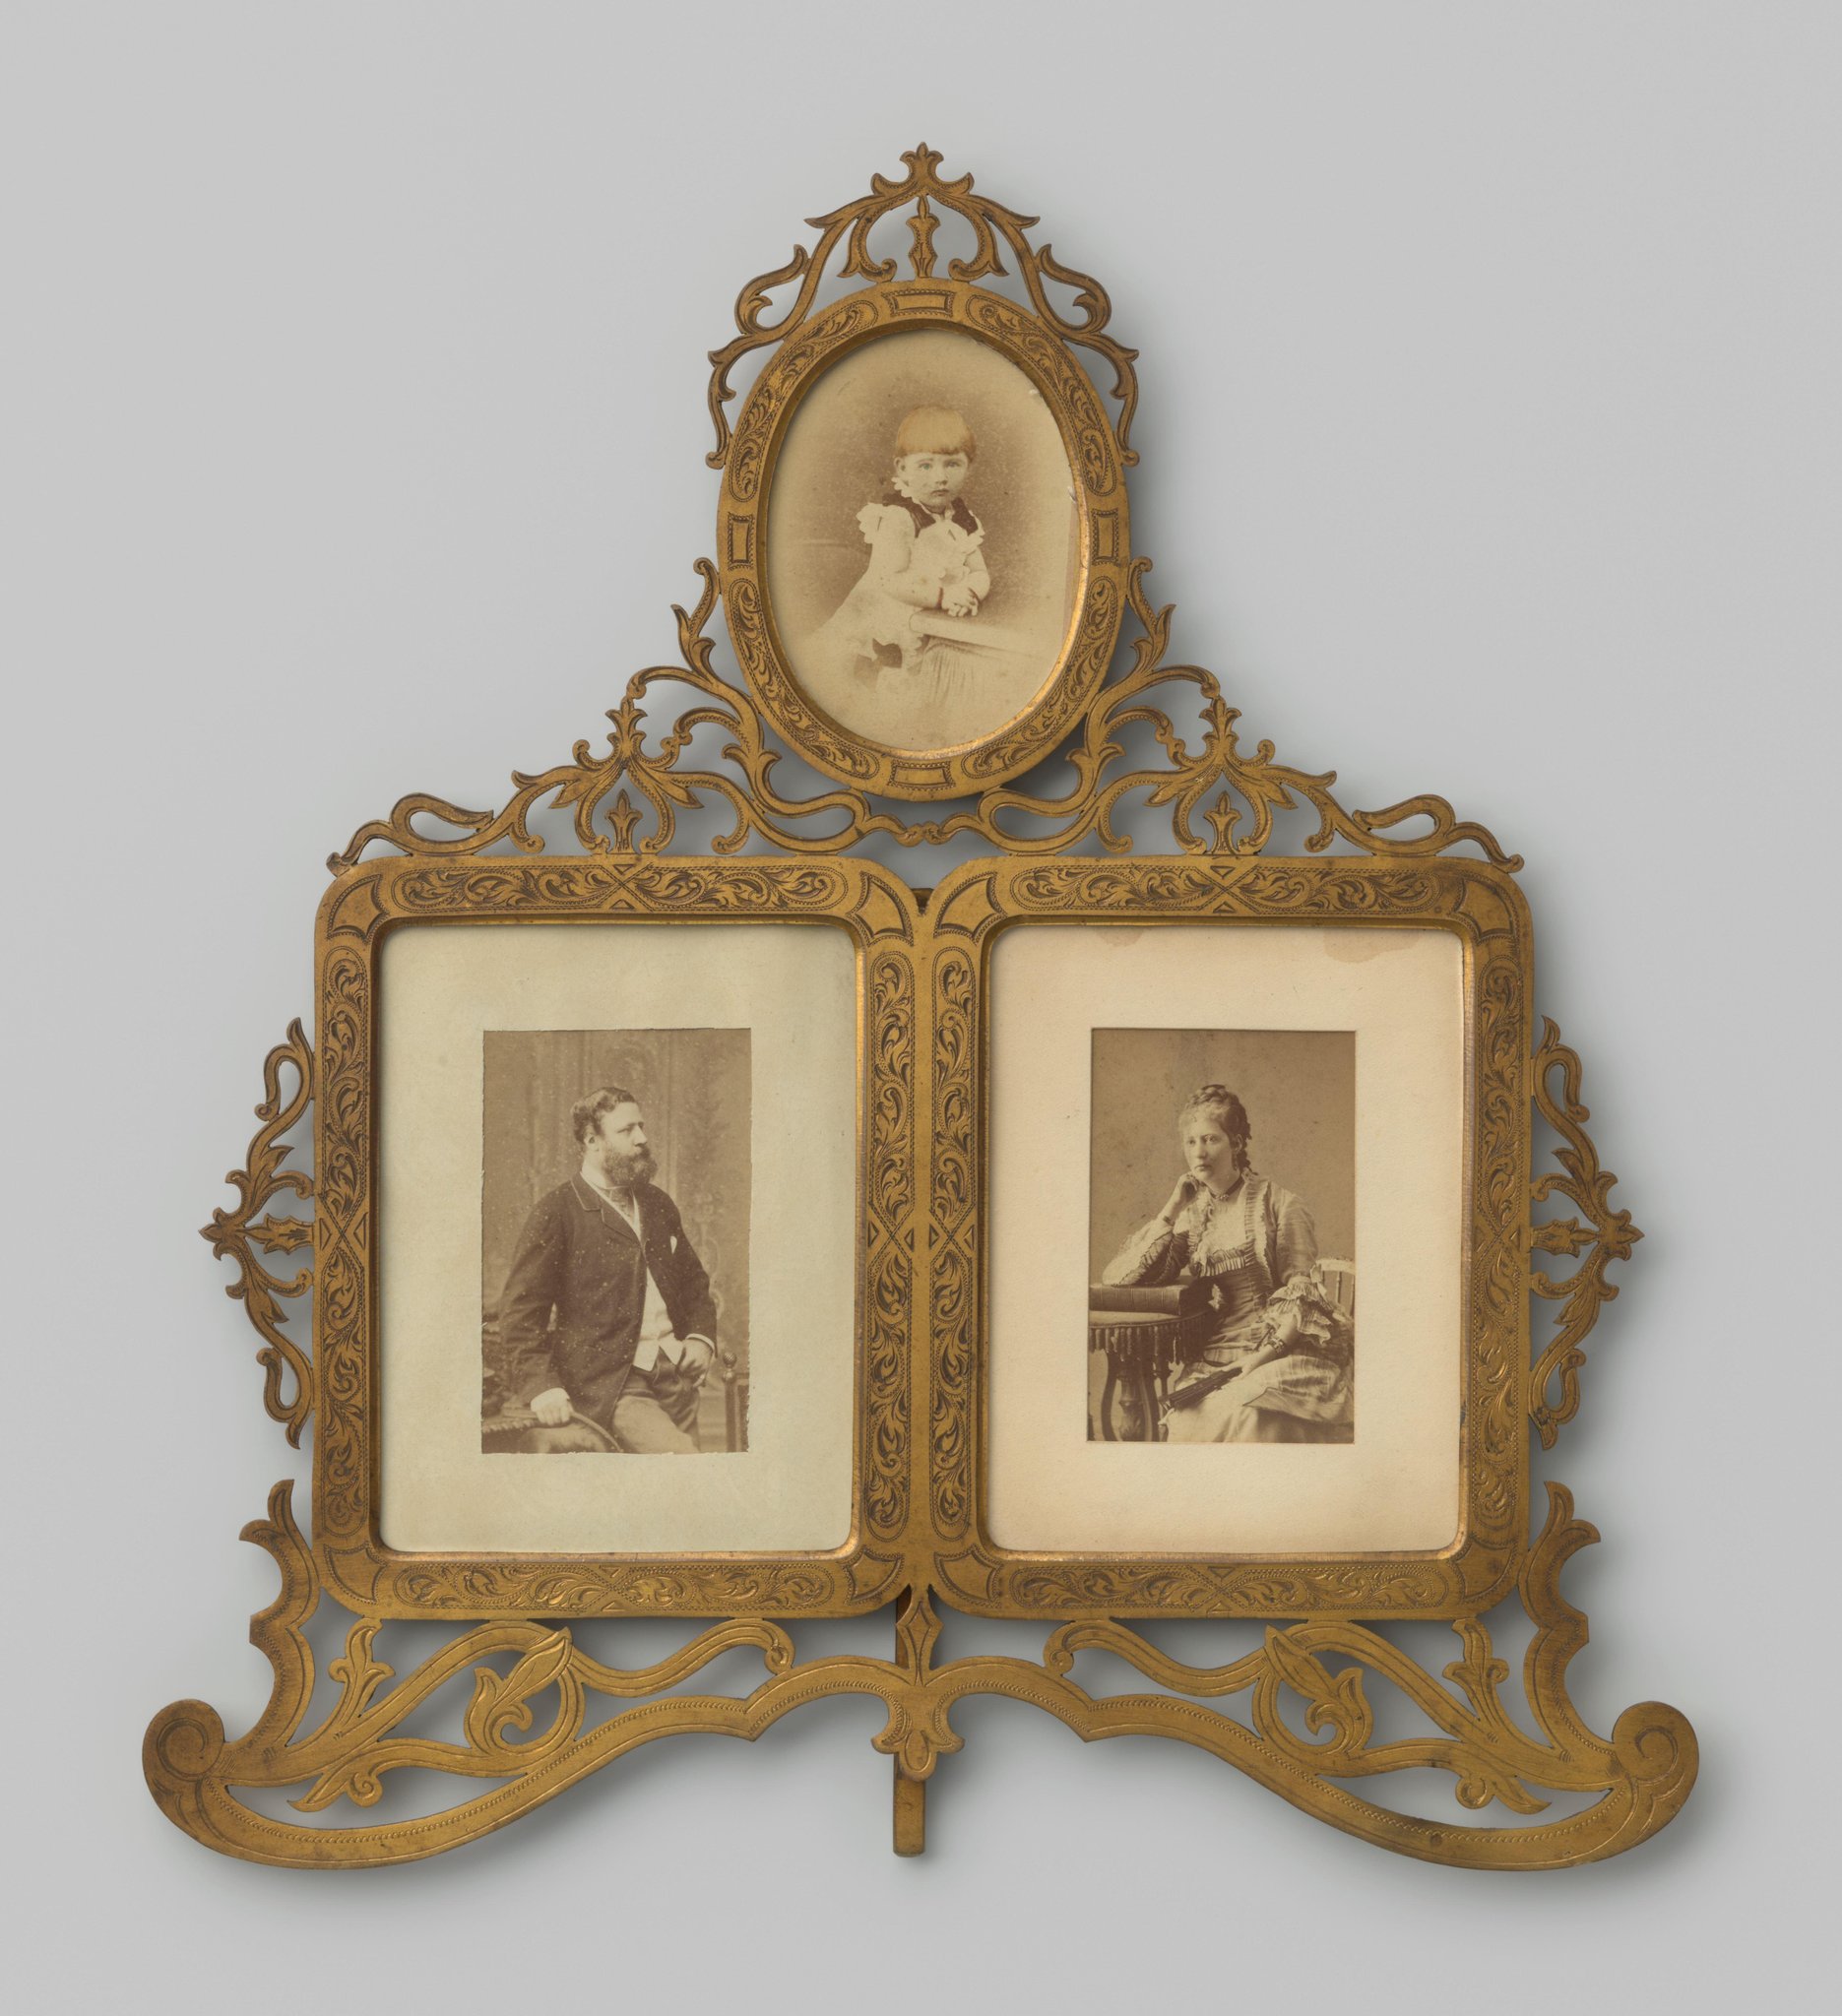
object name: photograph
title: Drie portretten van een onbekend kind, een onbekende man en vrouw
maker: Anonymous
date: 1880-1900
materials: cardboard, glass, metal, paper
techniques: albumen print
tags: adult woman, adult man, child, anonymous historical person portrayed